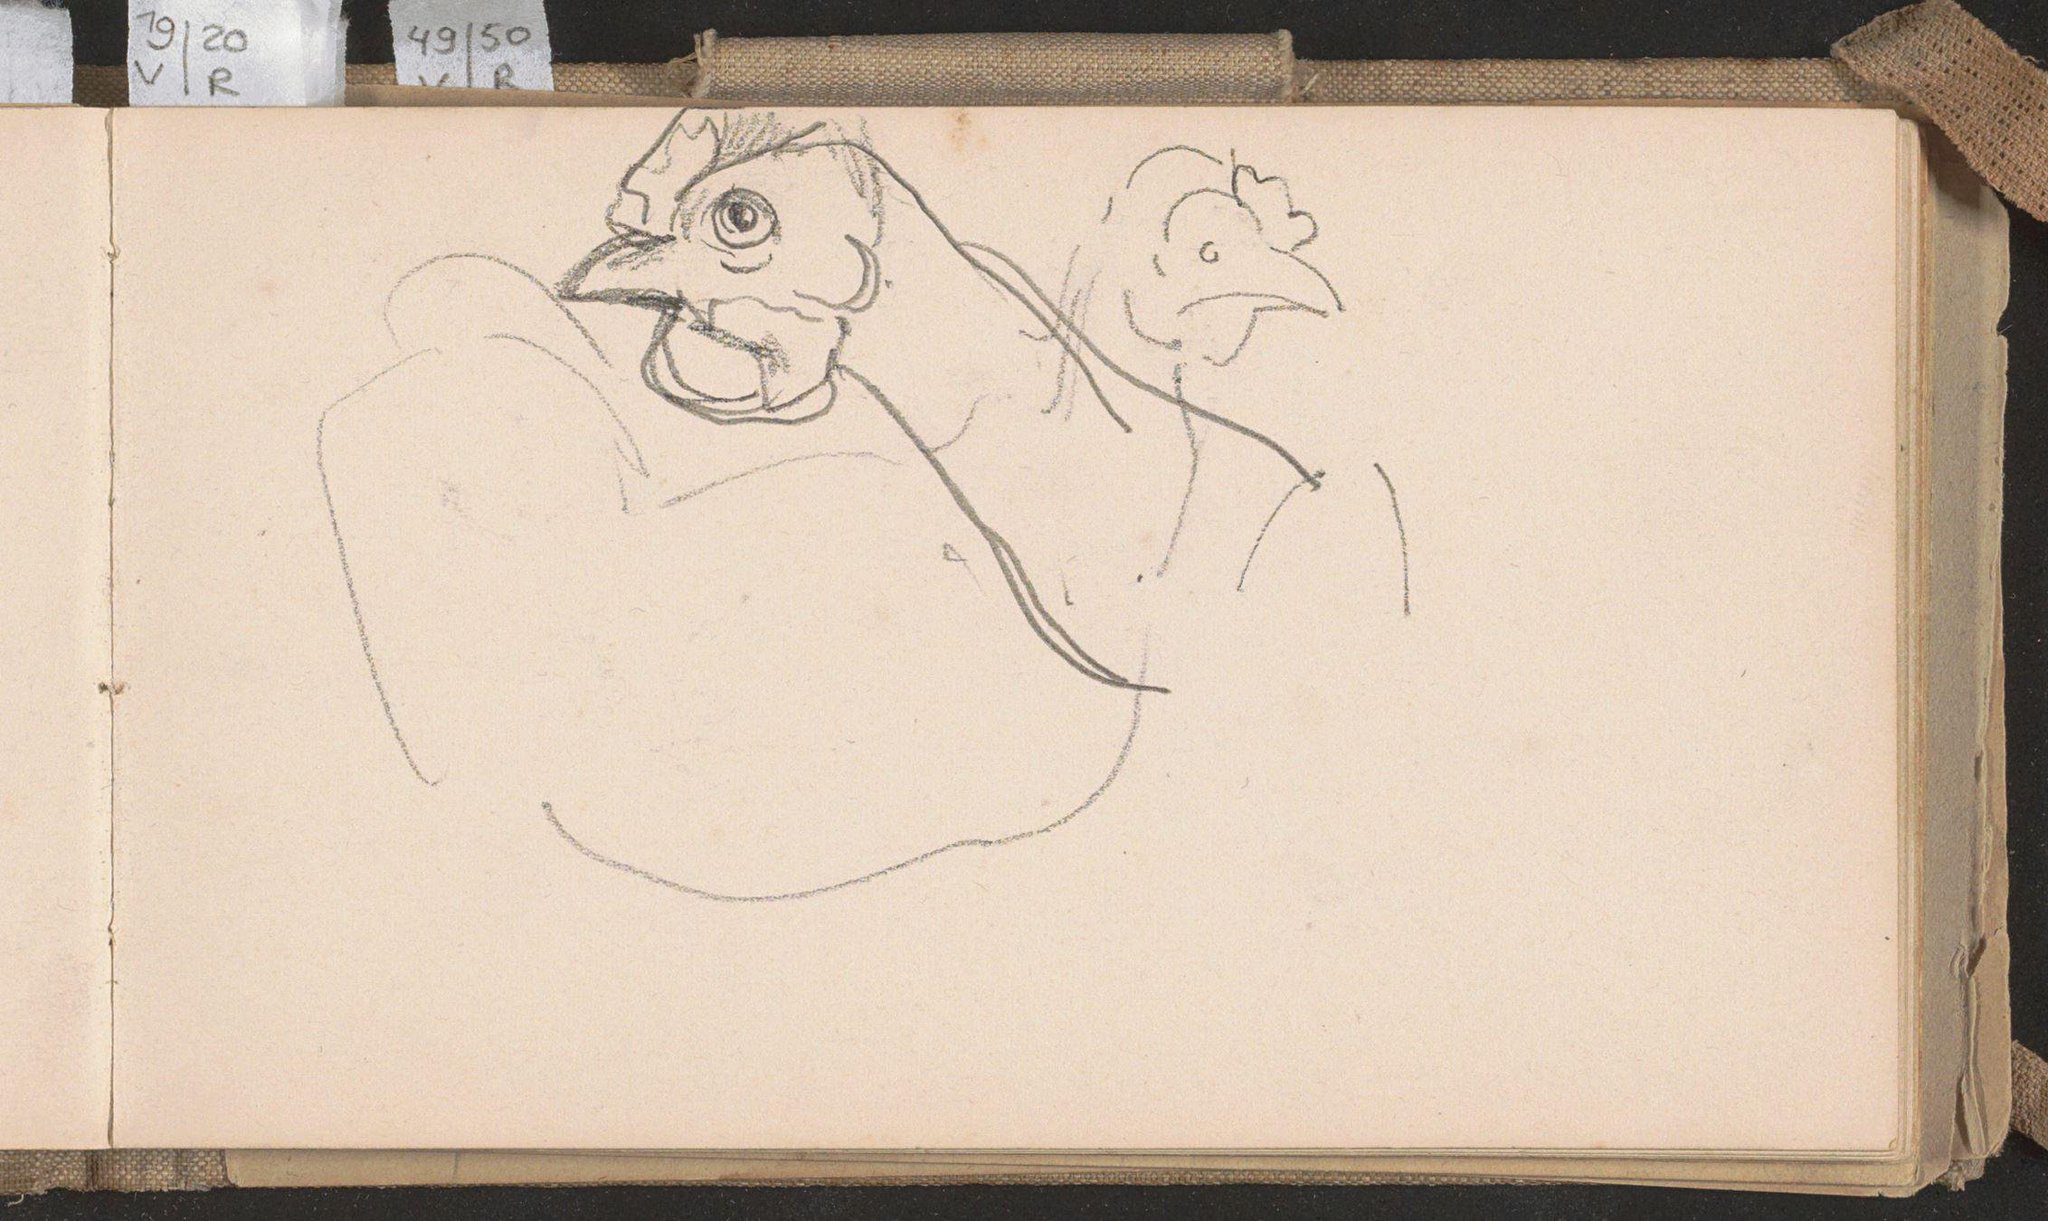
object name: sketchbook leaf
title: Kippen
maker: antoon derkinderen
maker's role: draughtsman, painter, print maker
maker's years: 1859-1925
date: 1892-1901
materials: paper, pencil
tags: plants (in general) (+ branch, stick)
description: Blad 15 recto uit een schetsboek met 51 bladen.